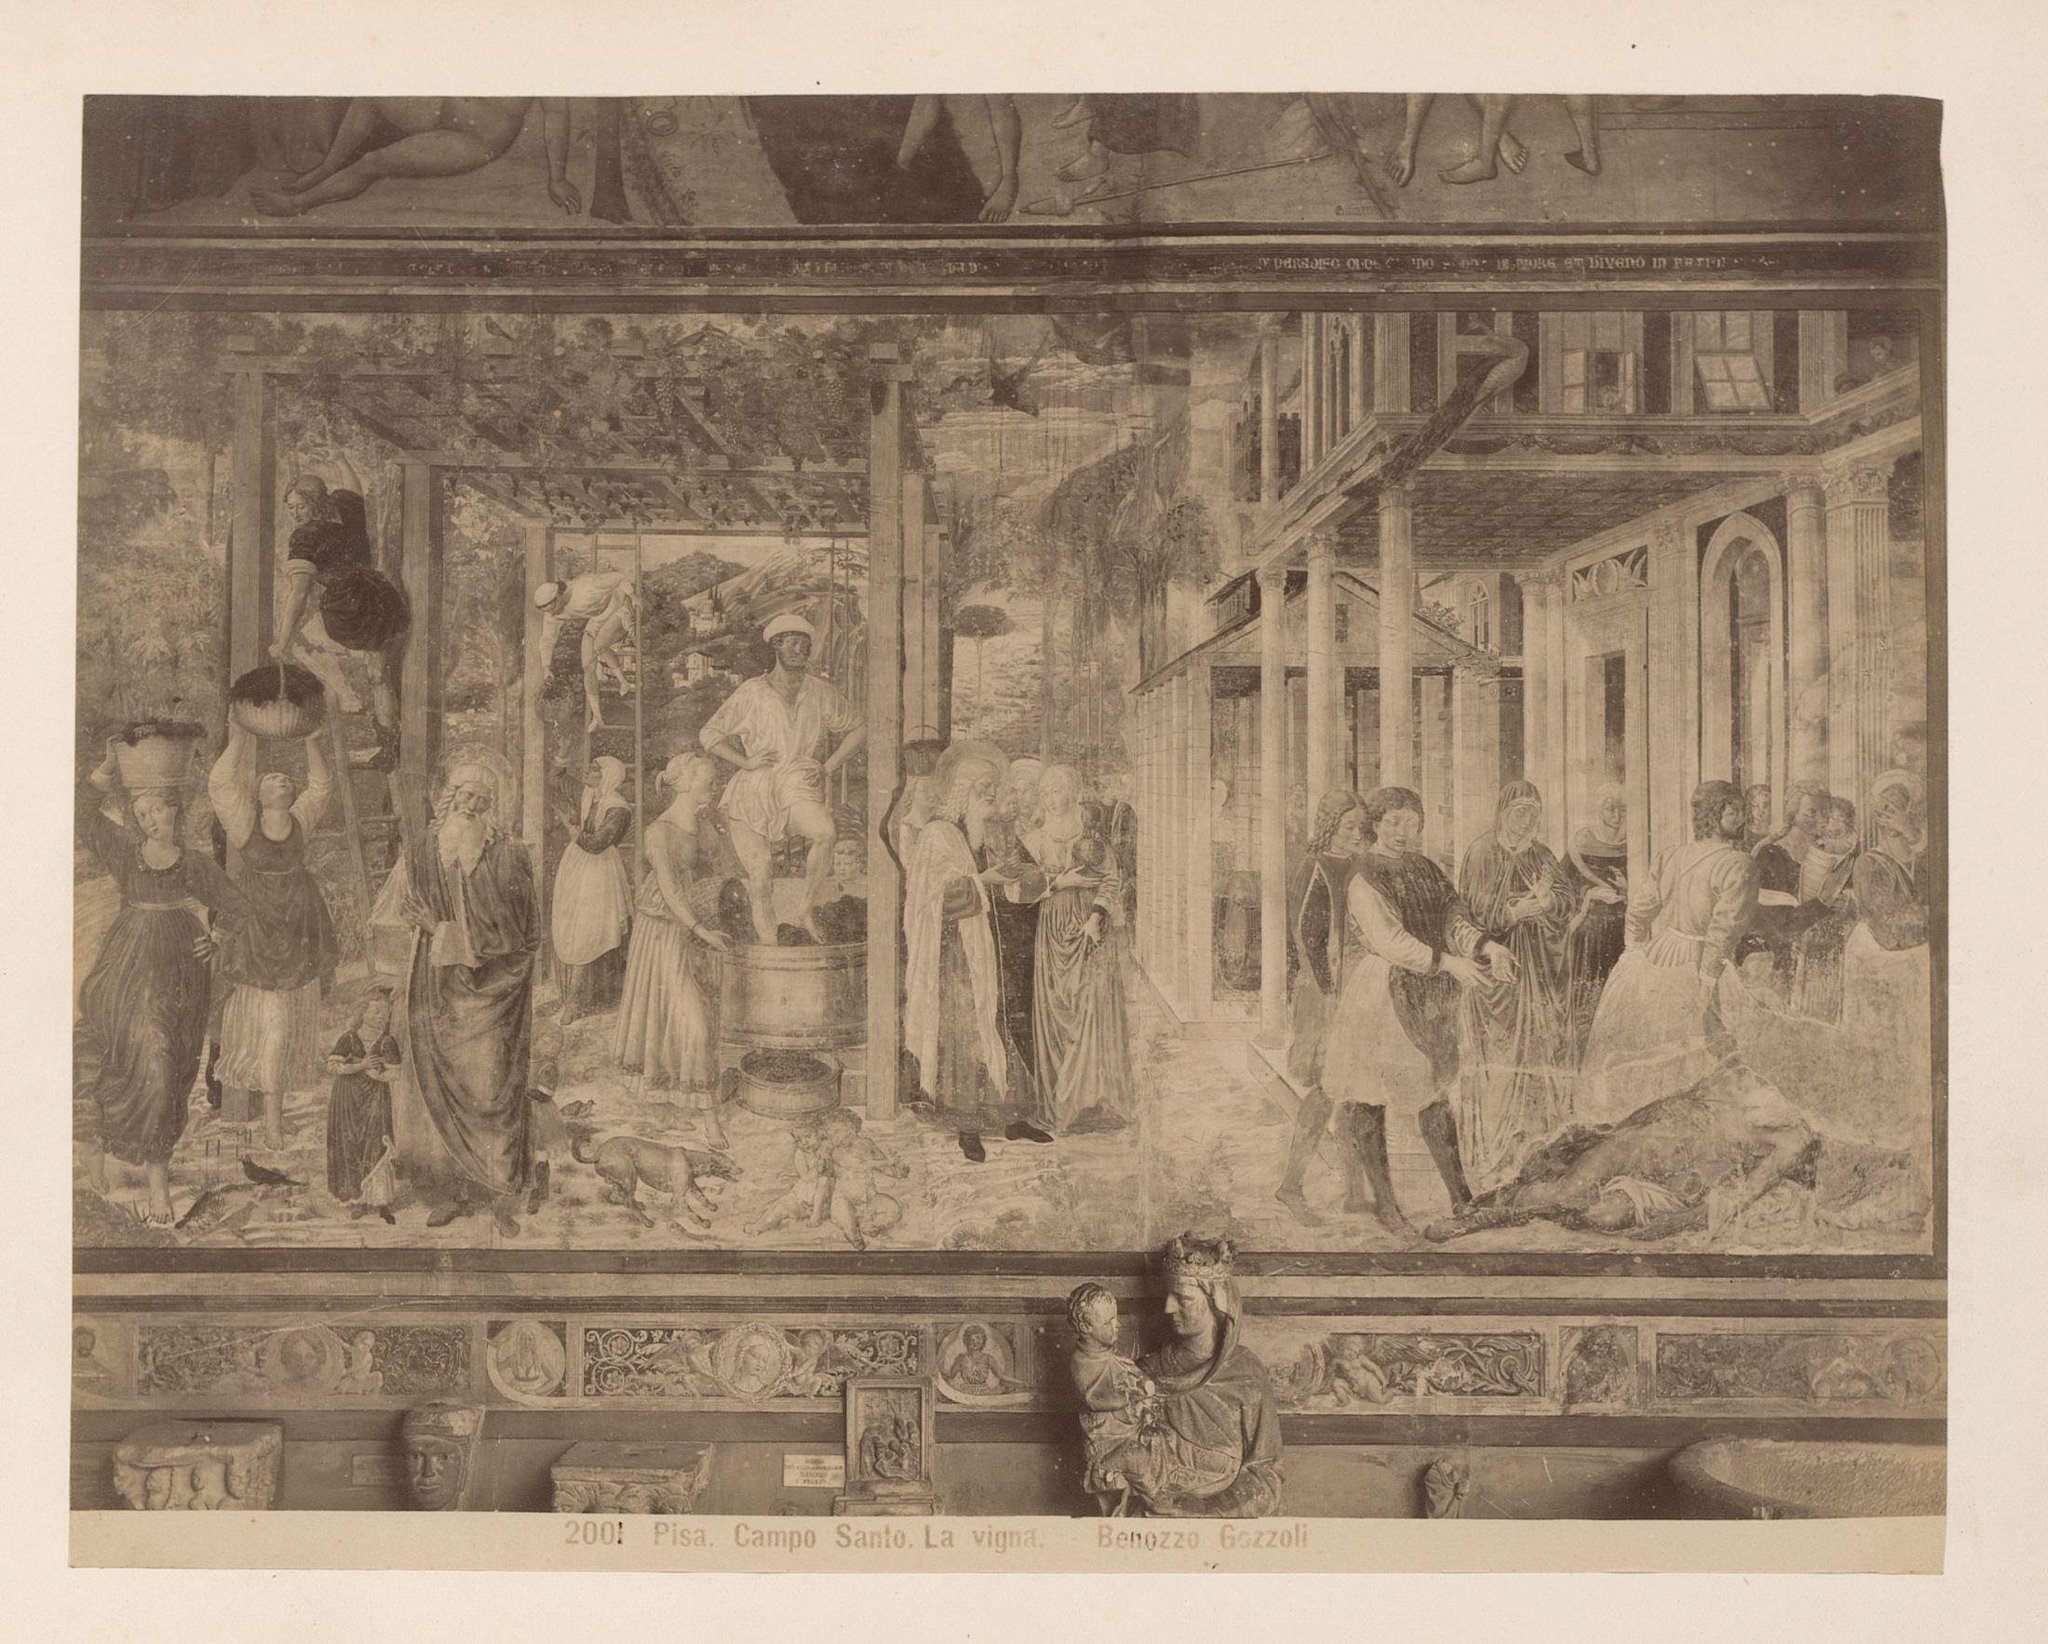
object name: reproduction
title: Pisa. Campo Santo. La vigna. Benozzo Gozzoli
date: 1860-1881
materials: paper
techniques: albumen print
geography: pisa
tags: the drunkenness of noah, picture, painting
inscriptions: number: ‘2001’